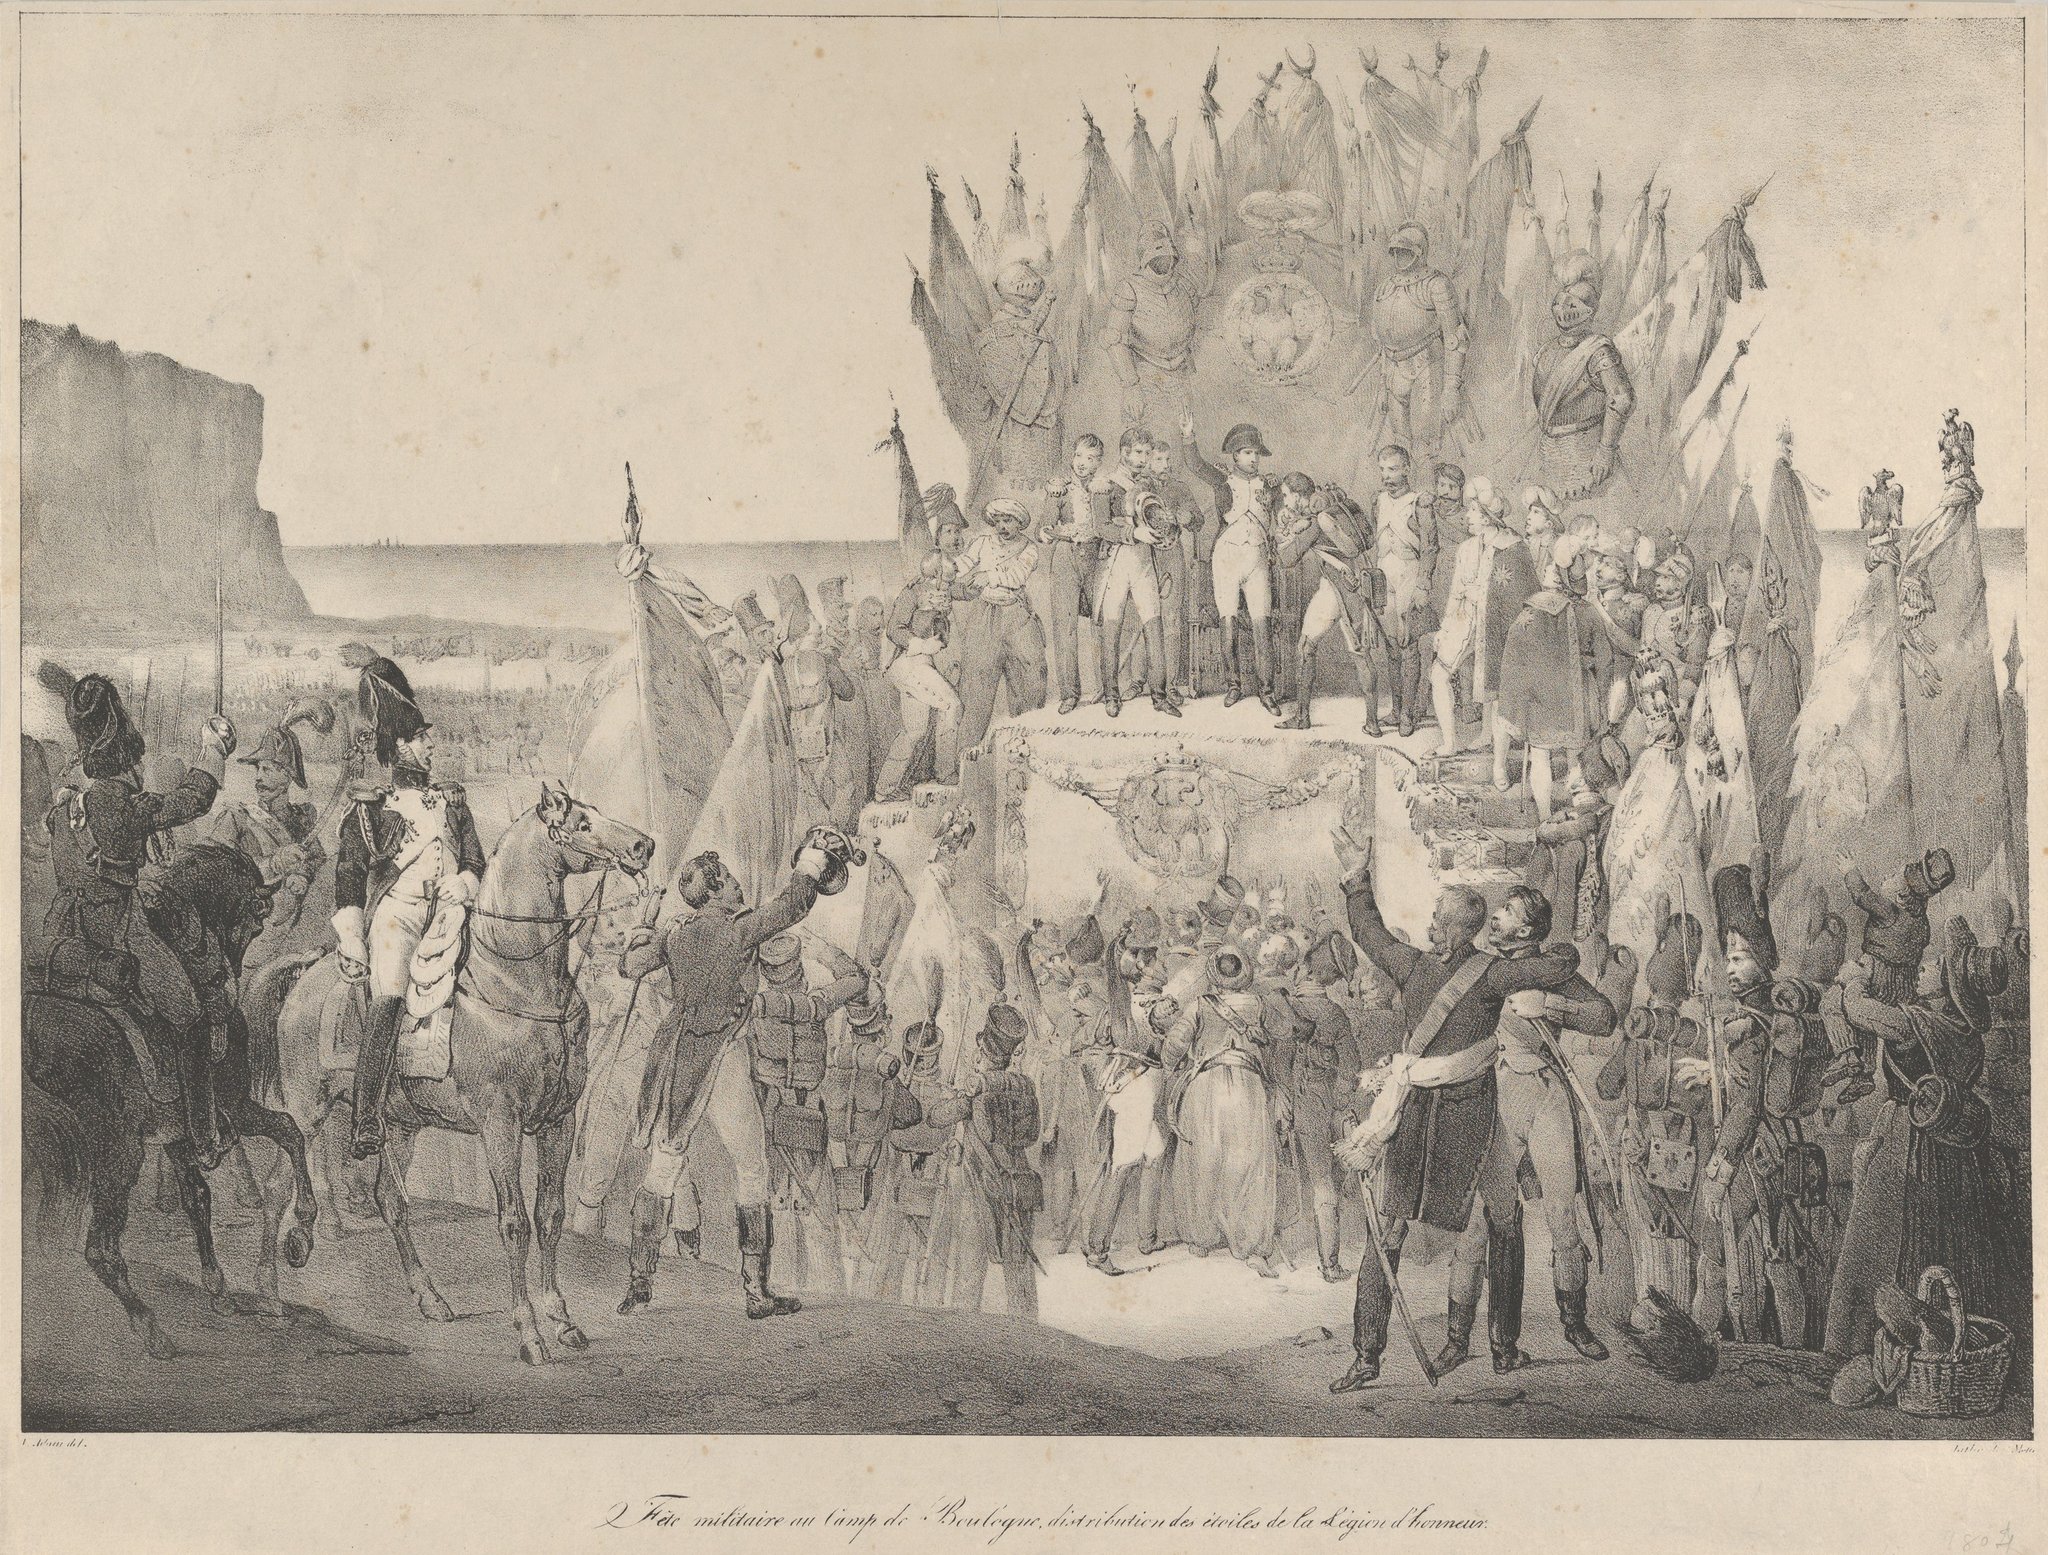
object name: print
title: Military Festival at Boulogne with Napoleon Distributing Stars of the Legion of Honor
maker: victor adam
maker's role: artist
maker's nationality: french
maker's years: 1801-1866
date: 1801-1900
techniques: lithograph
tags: military,men,horses